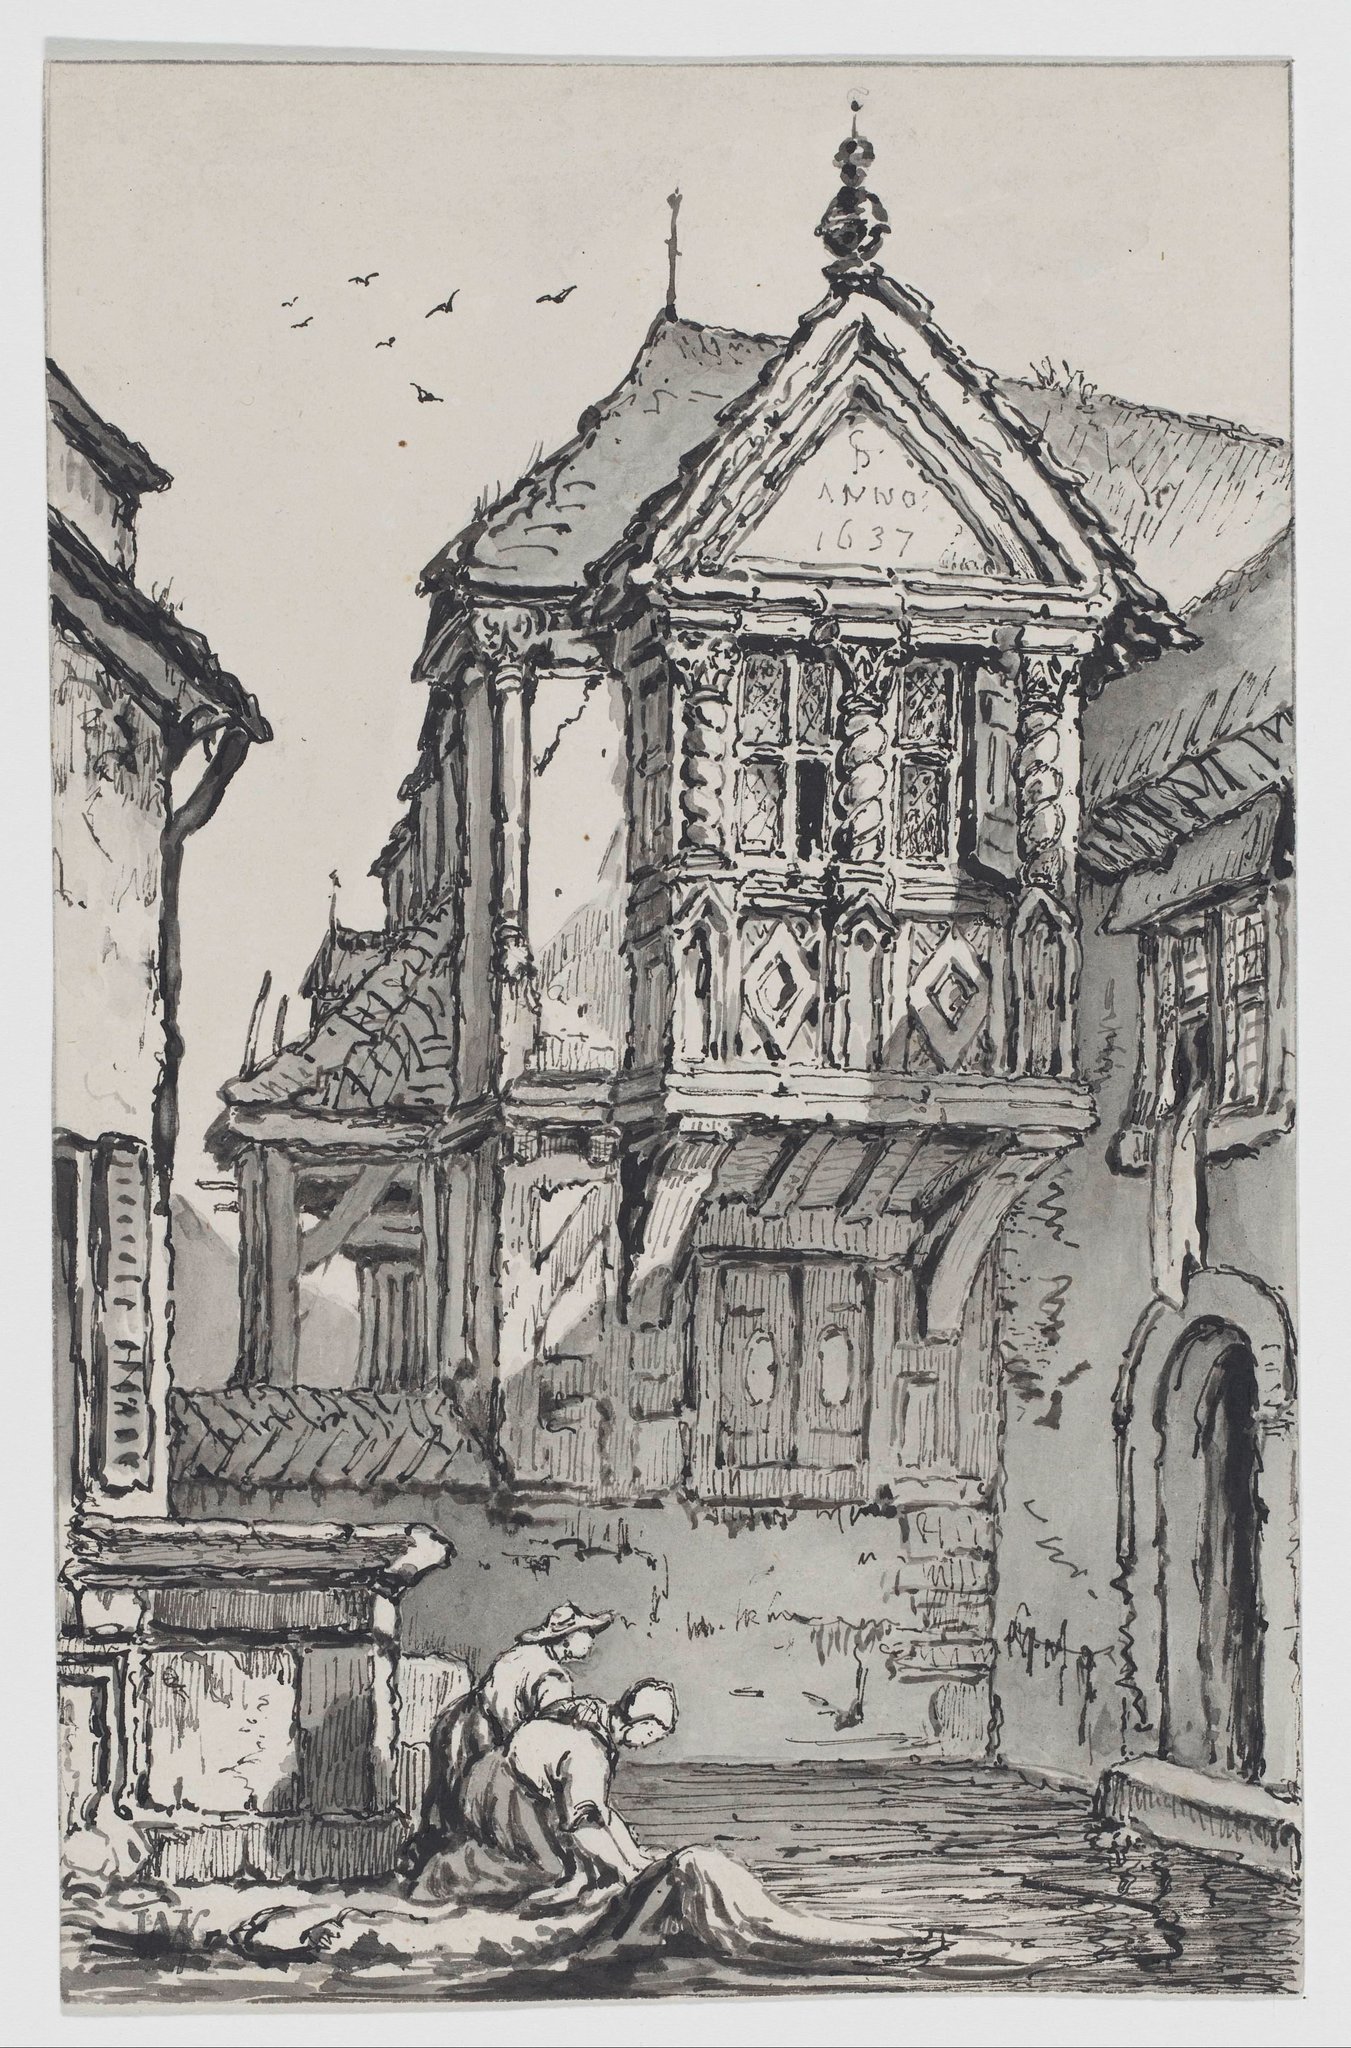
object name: drawing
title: Binnenplaats met twee vrouwen te Boppard in Duitsland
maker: isaac weissenbruch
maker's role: print maker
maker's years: 1826-1912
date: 1836-1912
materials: ink, paper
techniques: brush, pen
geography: boppard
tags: façade of inner court